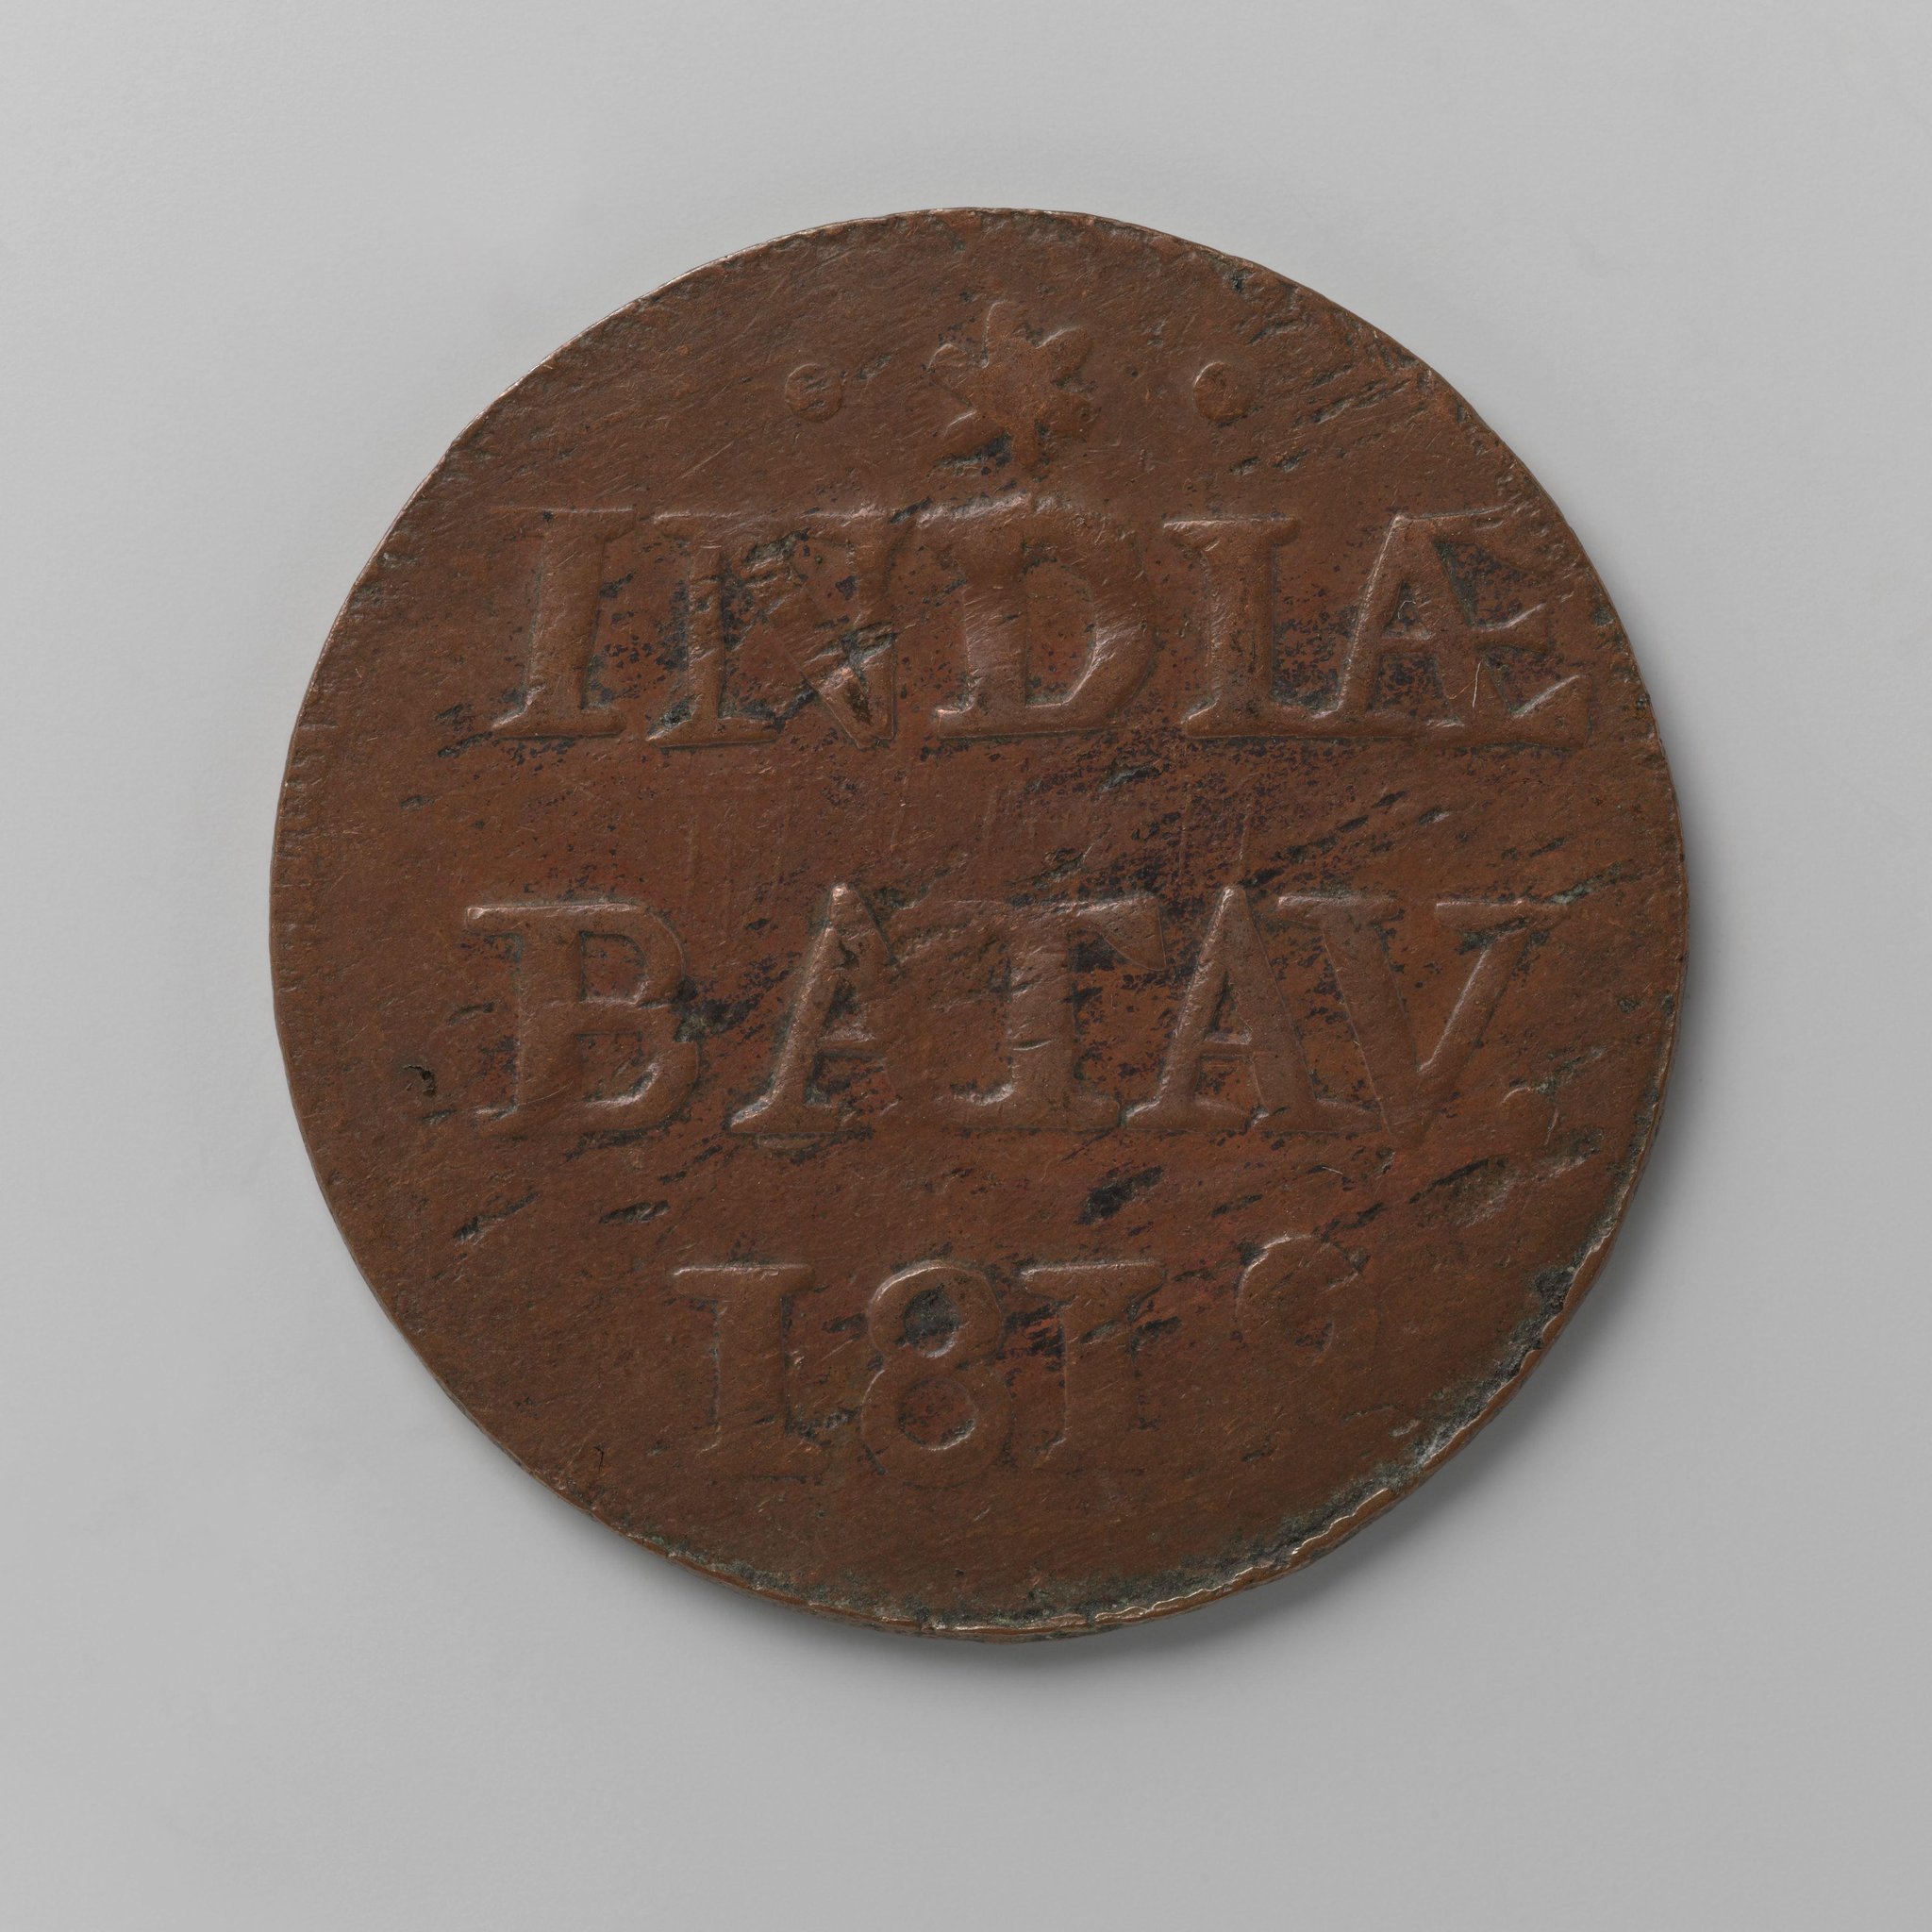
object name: coin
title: Nederlands Indië, ½ stuiver, 1819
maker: william i of the netherlands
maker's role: koning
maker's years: 1772-1843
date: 1819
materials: copper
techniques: striking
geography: surabaya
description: Koperen munt. Voorzijde: tussen waarde-aanduiding ½ St. gekroond generaliteitswapenschild. Daaronder letter G [=gulden!]. Keerzijde: tweeregelig opschrift, waarboven muntteken en waaronder jaartal. Gladde rand.